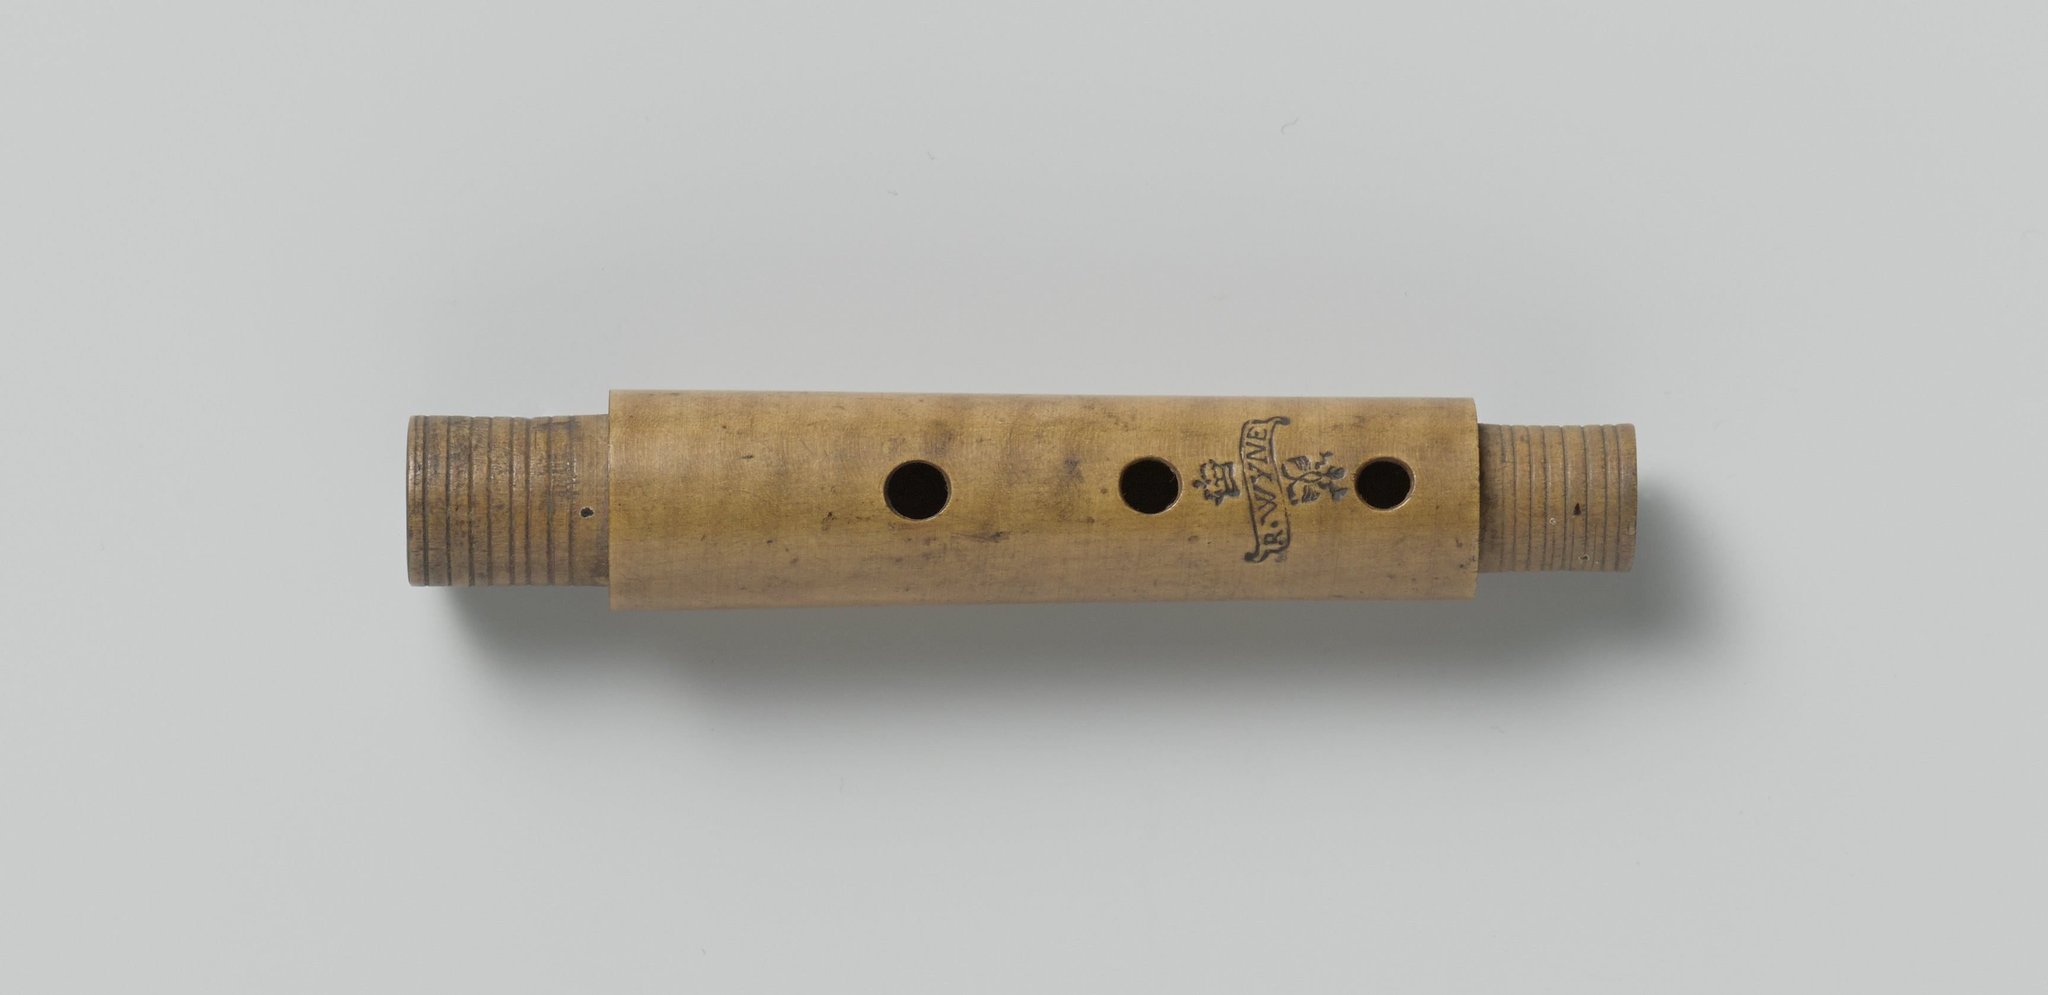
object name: transverse flute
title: Piccolo (middle joint)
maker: robert wijne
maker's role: musical instrument maker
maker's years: 1698-1774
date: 1750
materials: wood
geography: nijmegen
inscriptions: stamp: ‘R.WYNE’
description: Middendeel van een piccolo met drie gaten.